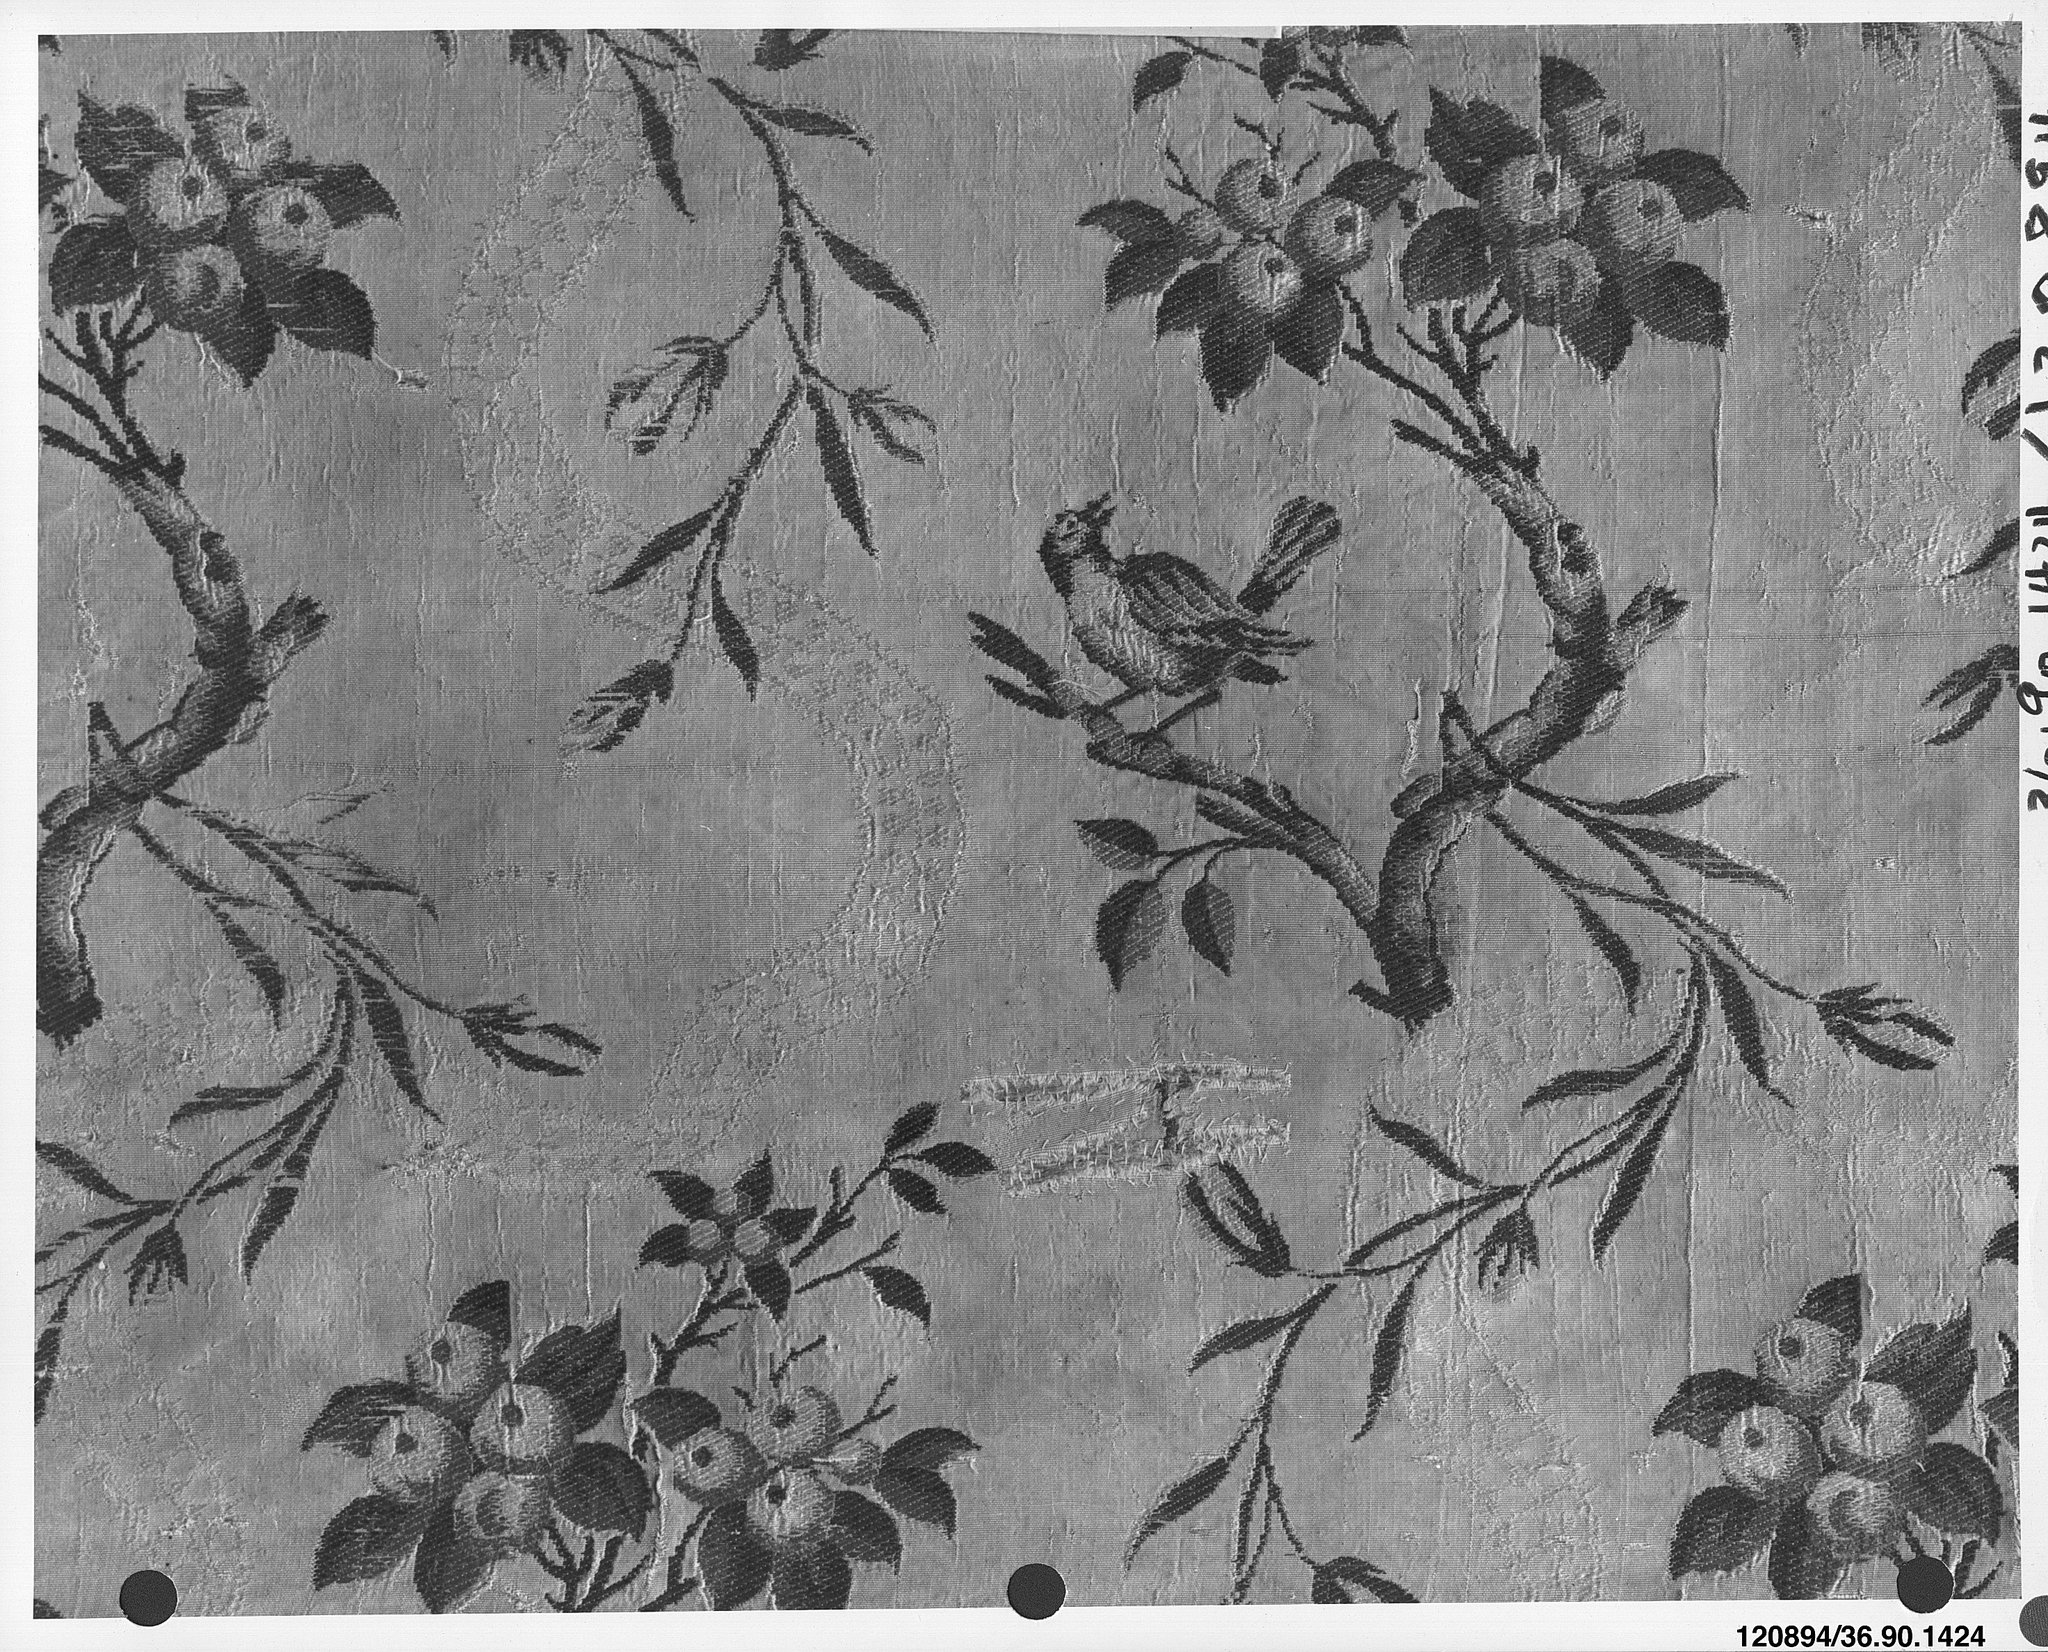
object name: piece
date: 1760-1770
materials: silk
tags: birds,fruit,leaves